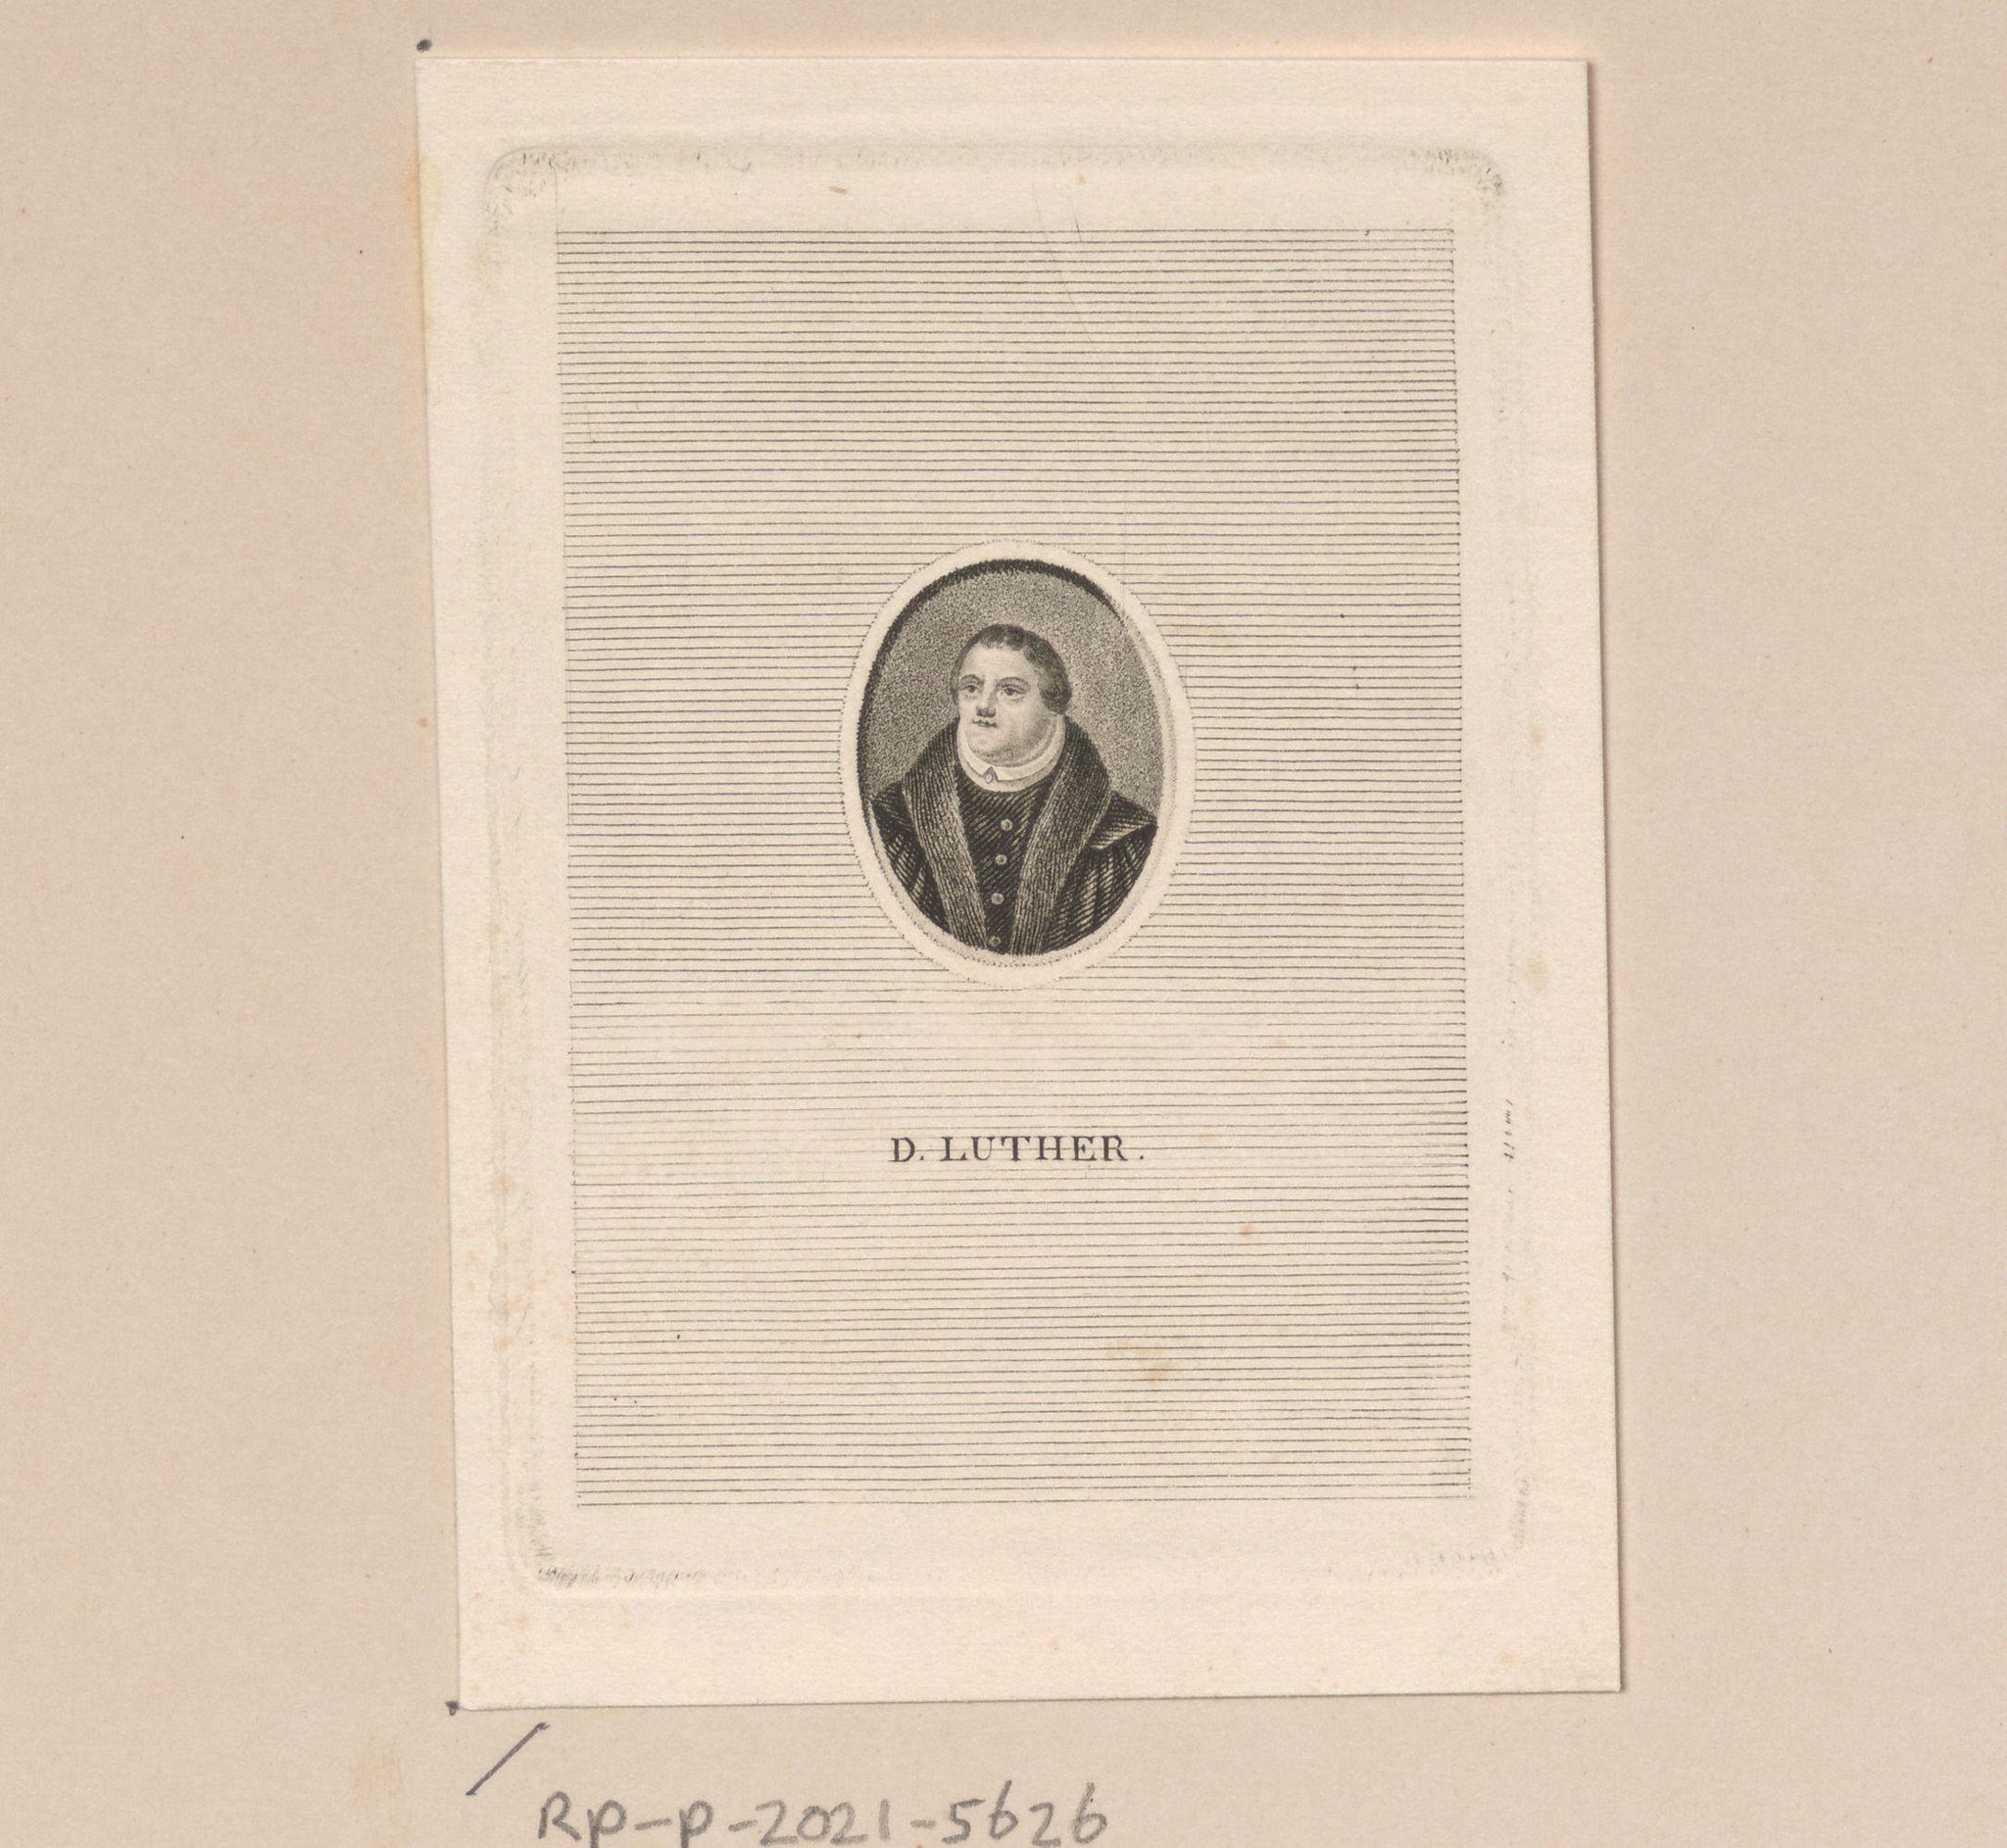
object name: print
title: Portret van Martin Luther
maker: Anonymous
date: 1700-1799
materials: paper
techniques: etching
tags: priest, martin luther, theologian, ornament ~ medallion, historical persons